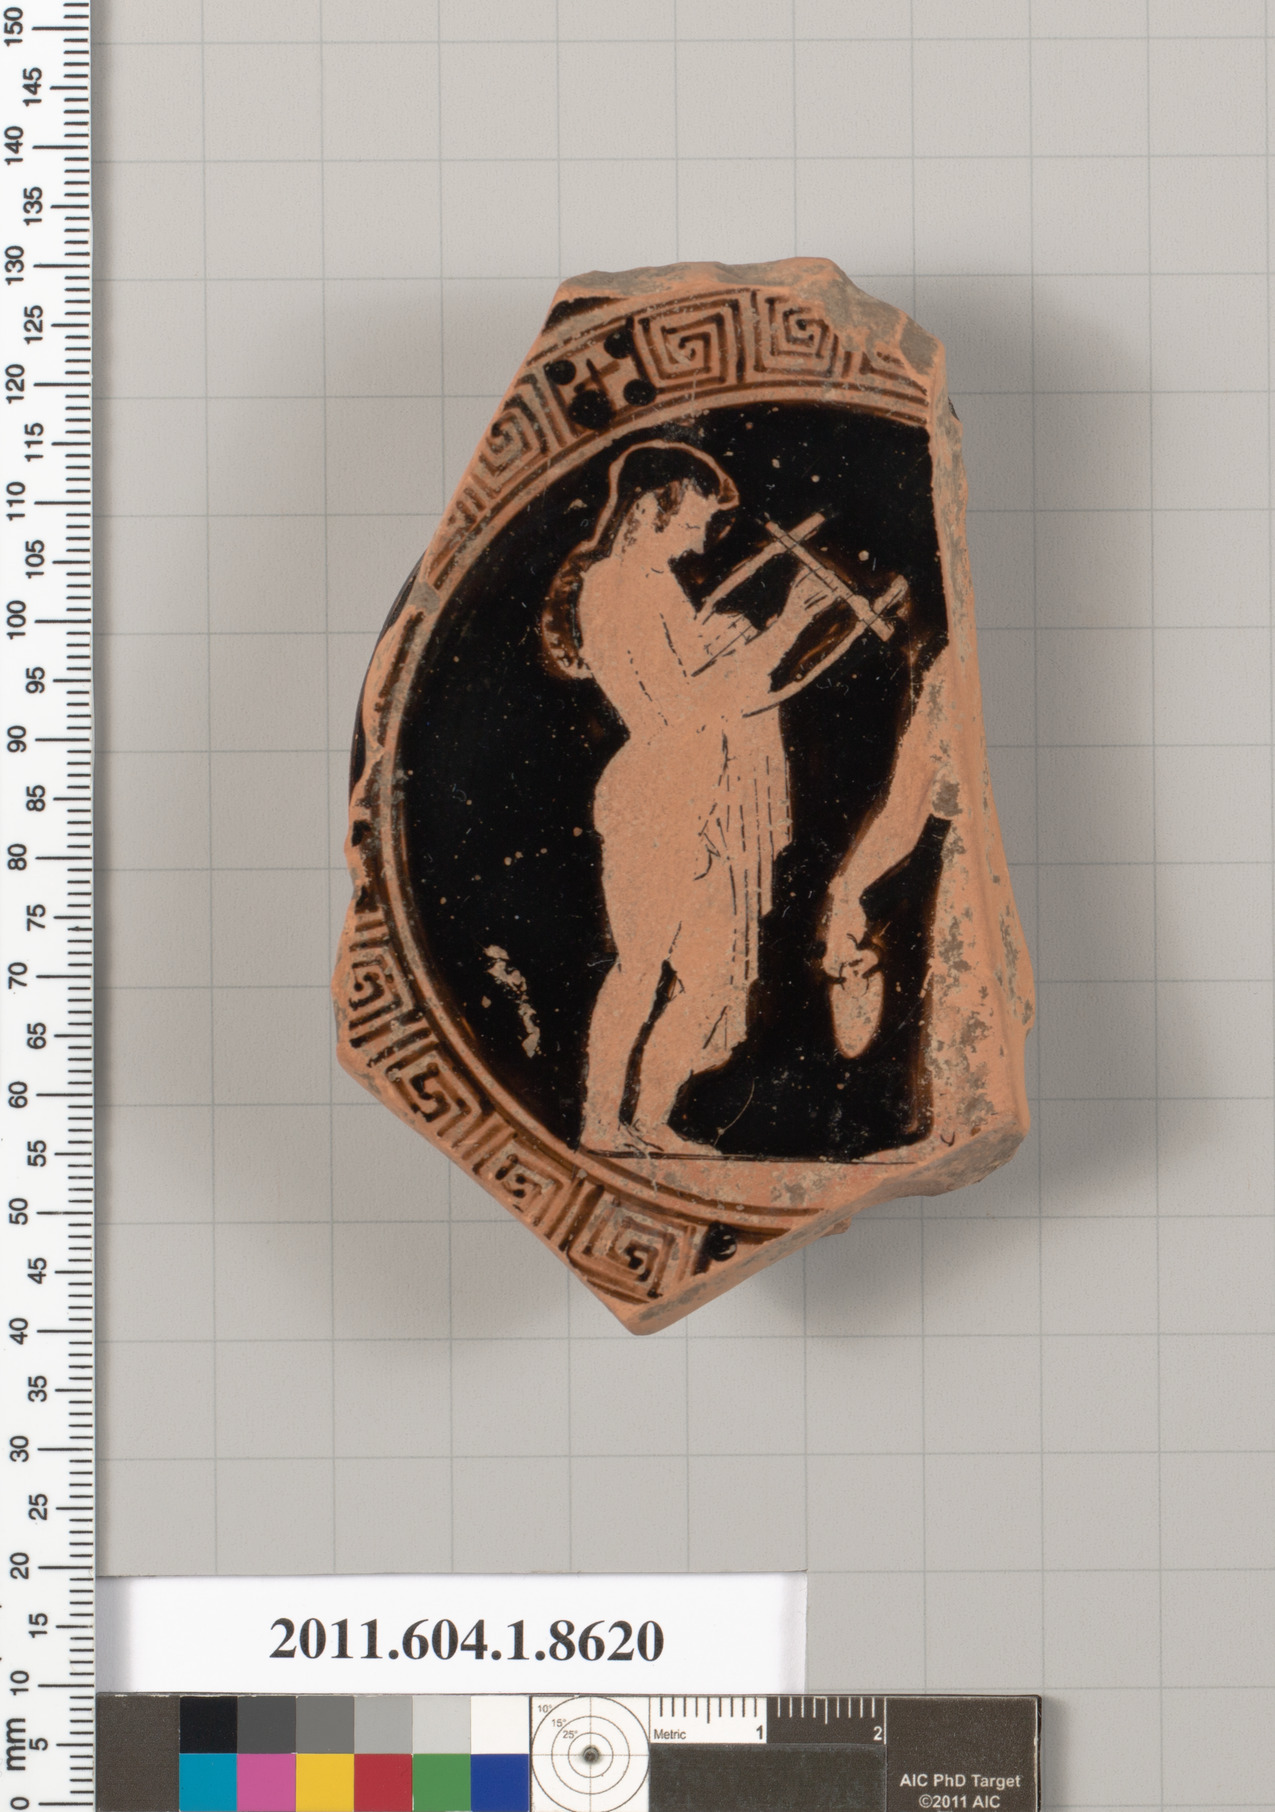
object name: kylix fragment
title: Terracotta fragment of a stemless kylix (drinking cup)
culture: greek, attic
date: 460-450 BCE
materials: terracotta